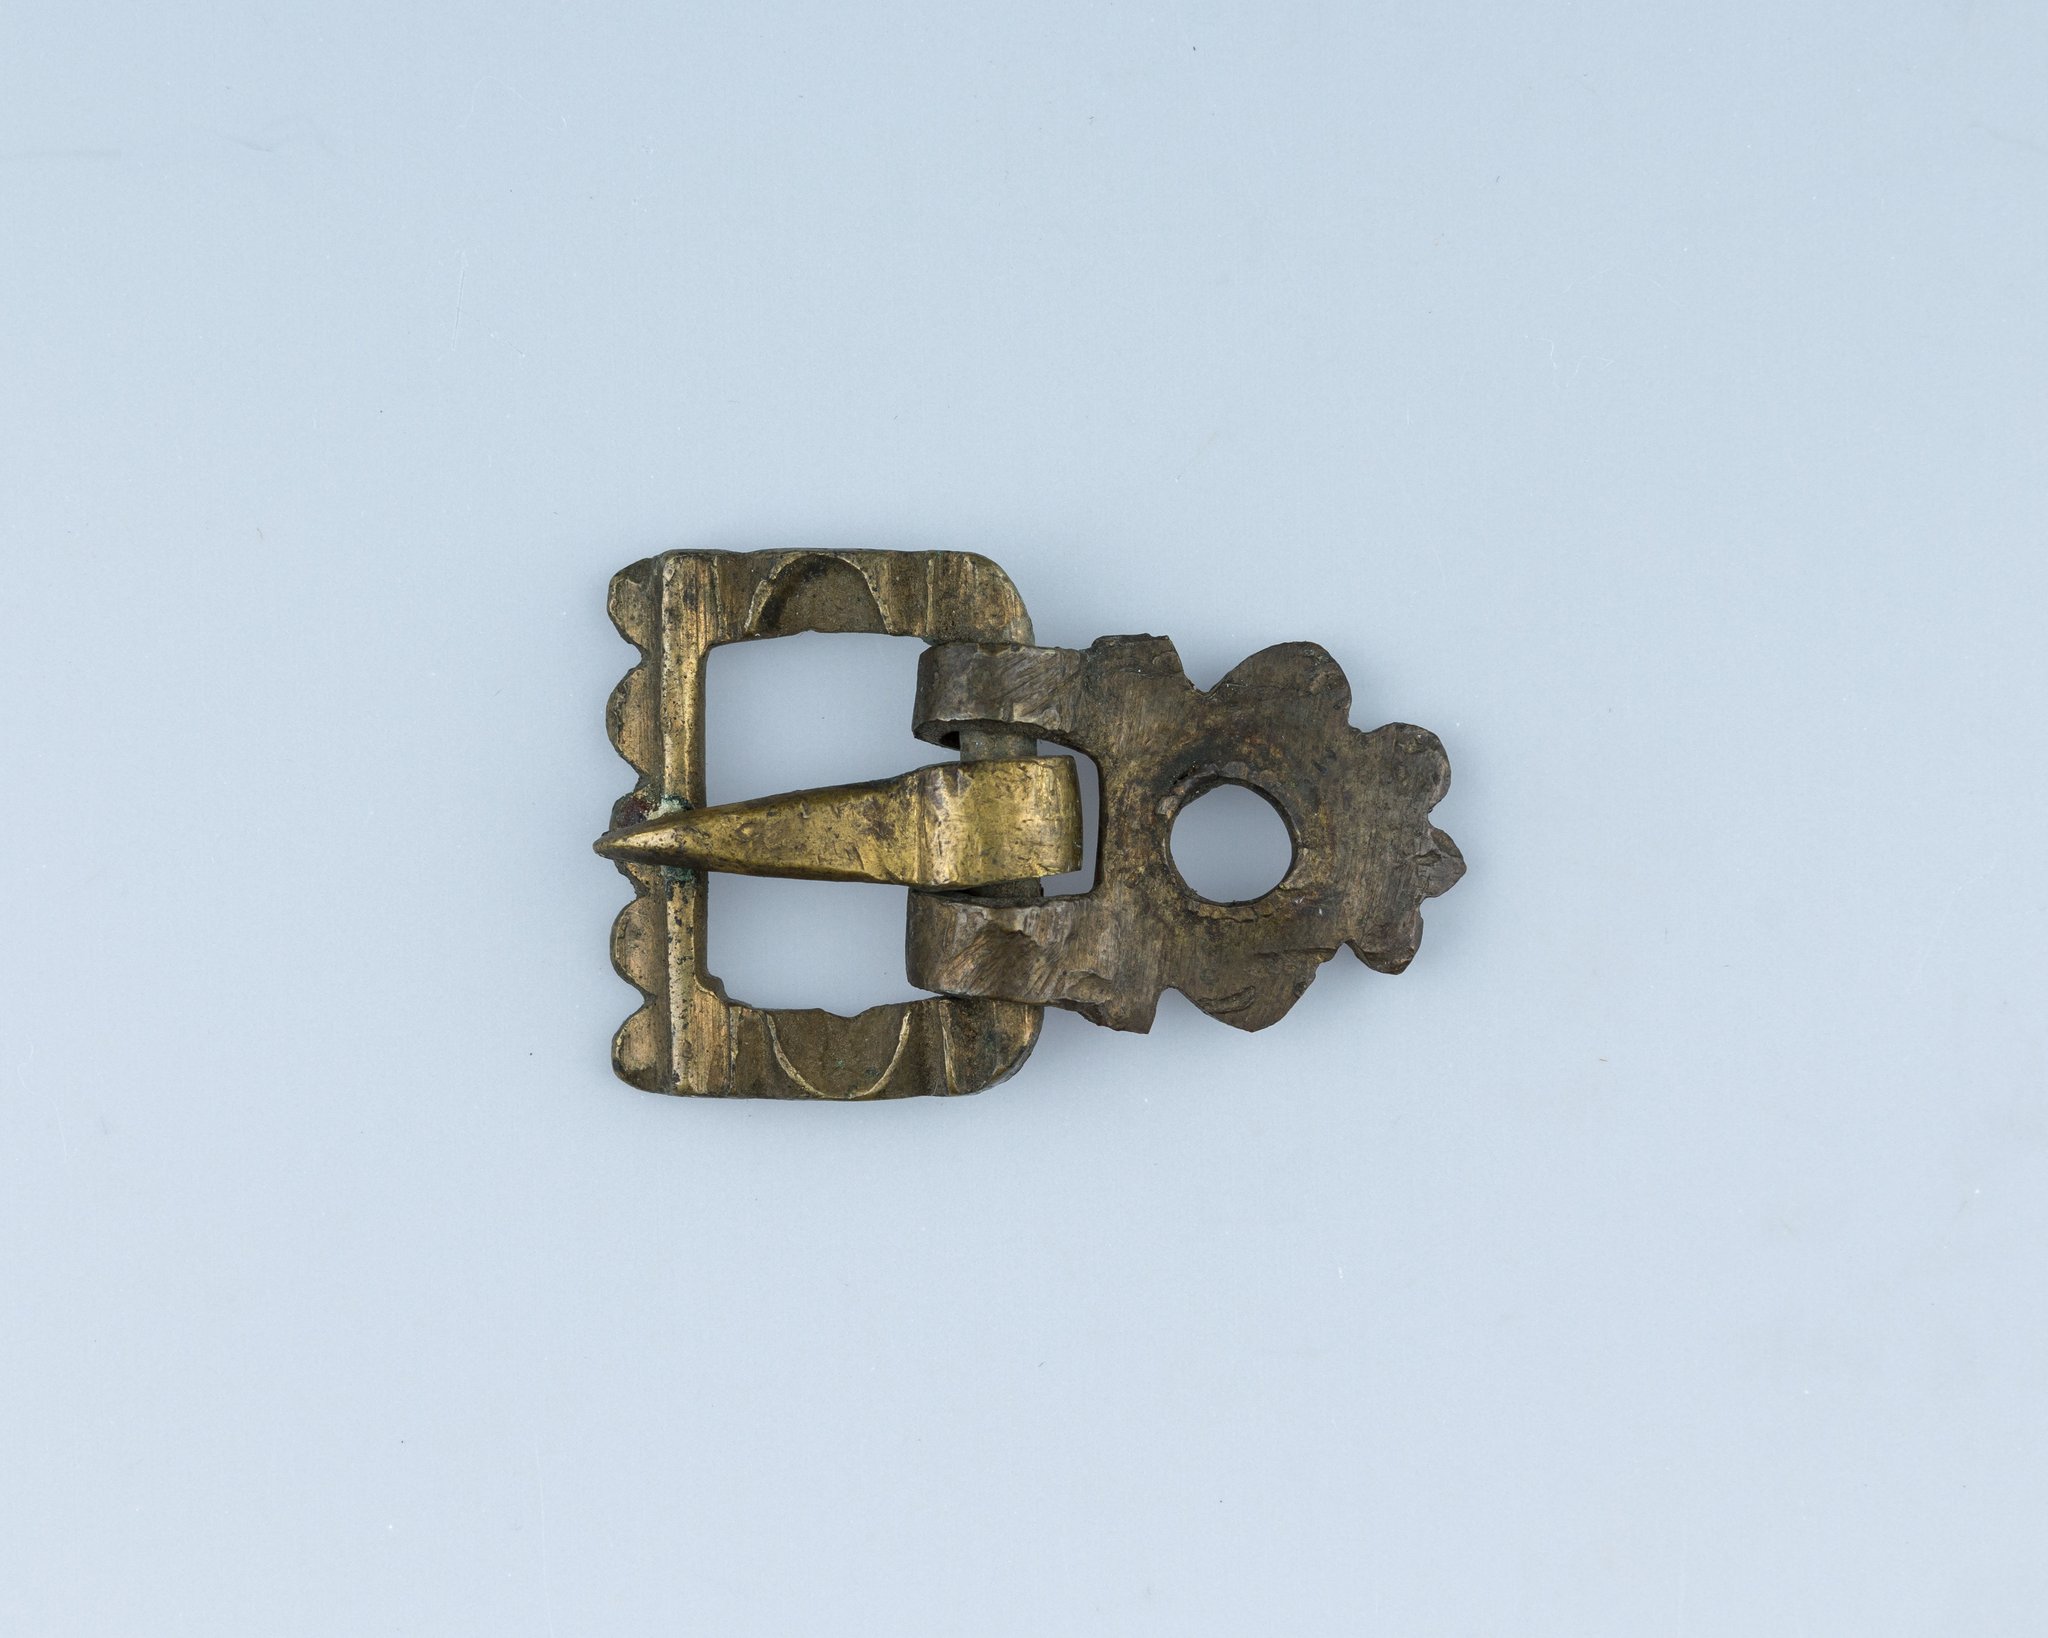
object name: buckle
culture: german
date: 1510-1520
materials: brass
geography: germany